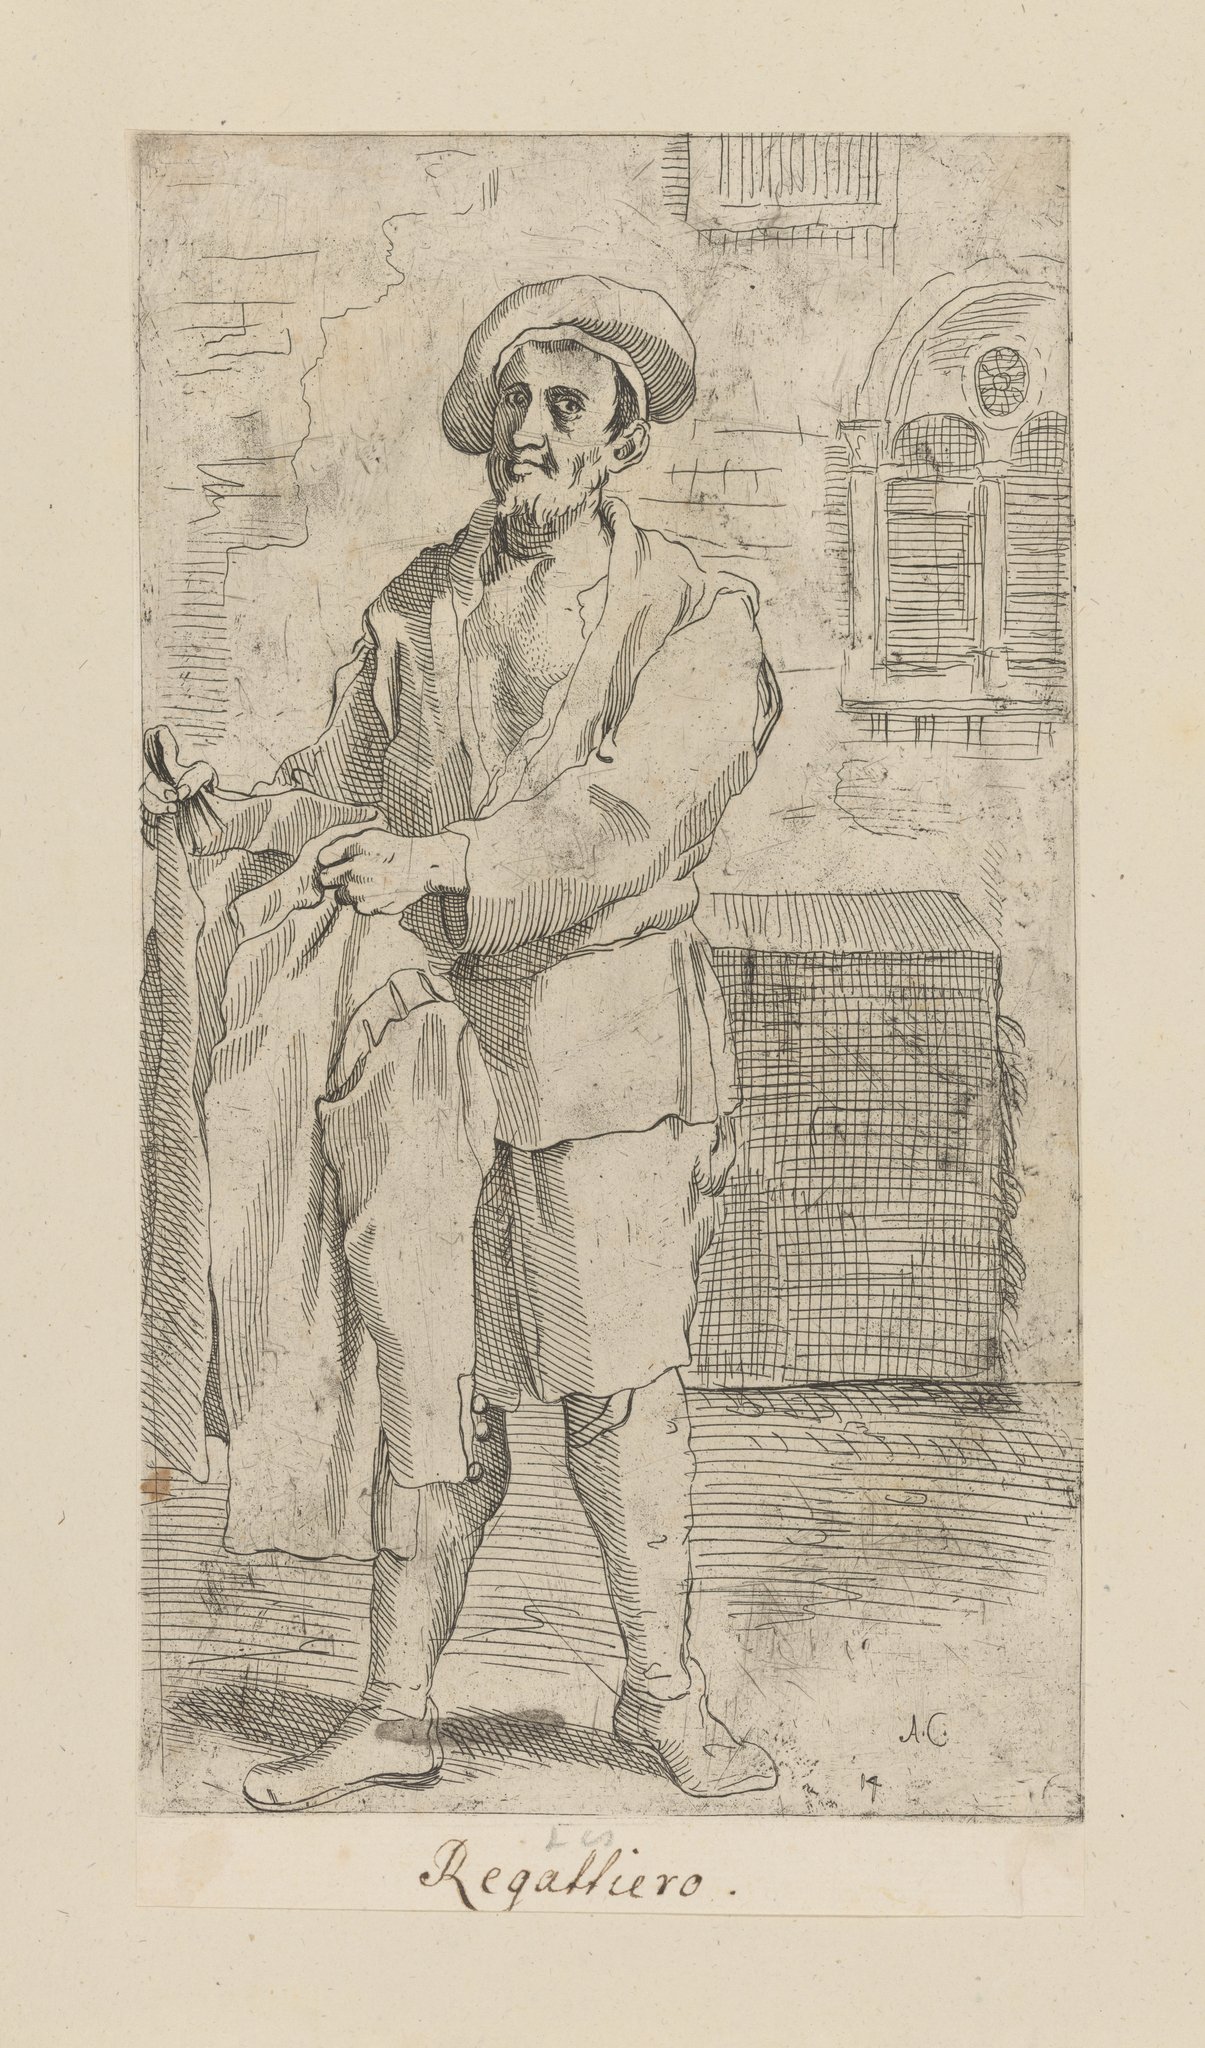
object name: print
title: Plate 14: Vendor of old clothes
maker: simon guillain ii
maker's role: artist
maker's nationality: french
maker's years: 1618-1718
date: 1646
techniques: etching